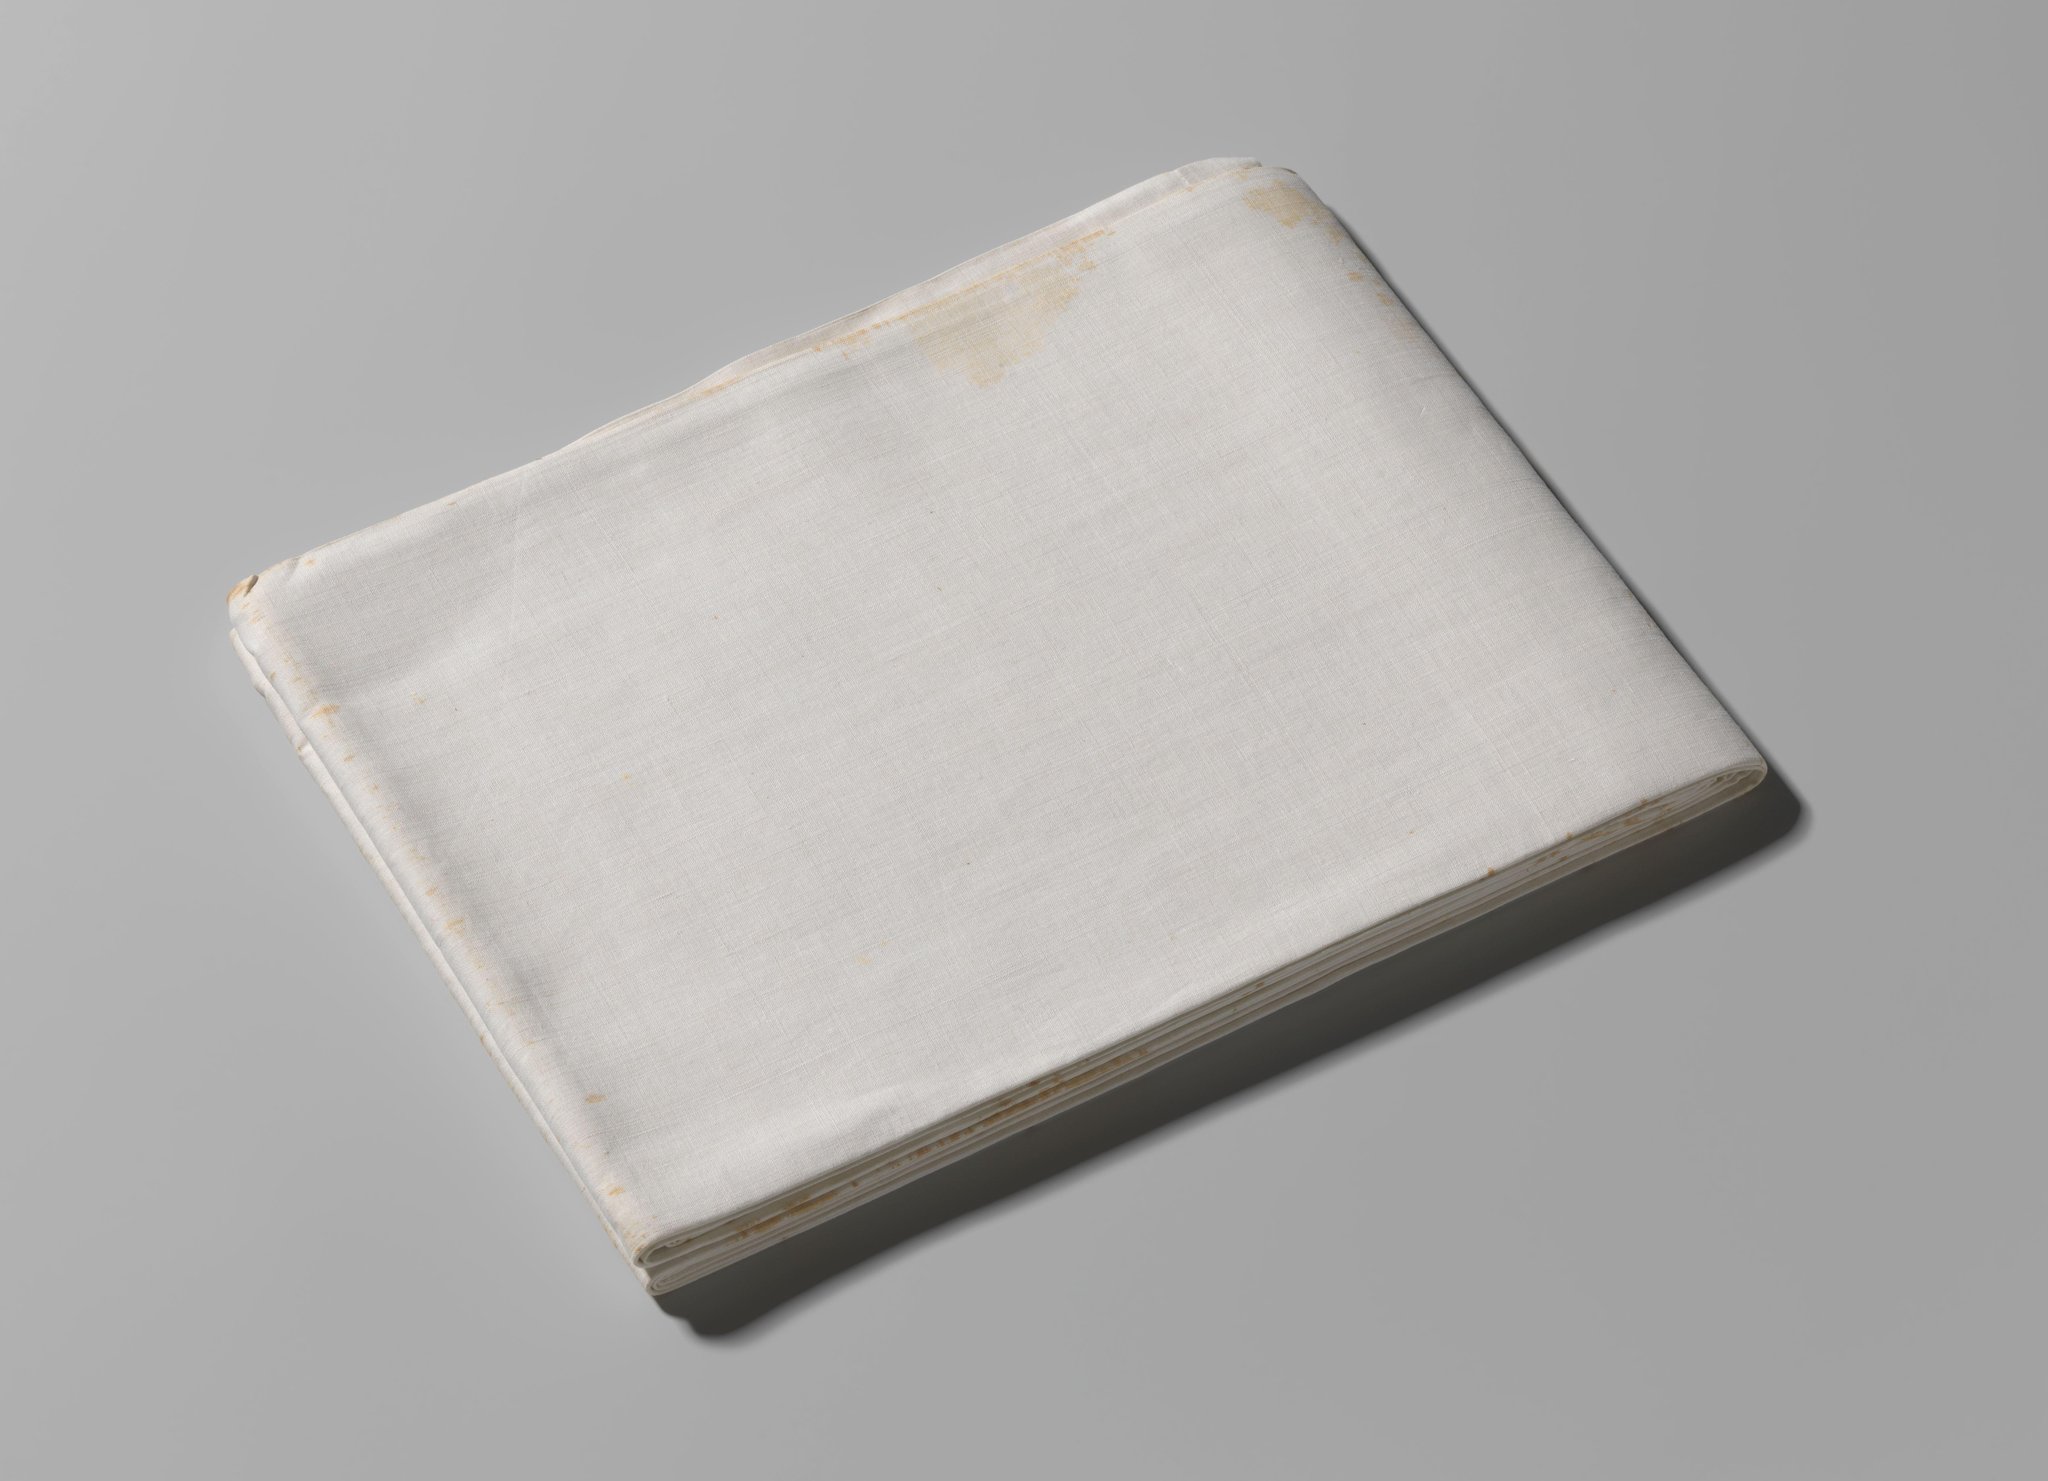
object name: beddenlaken, laken object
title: Laken. Merk: HW14 en jaartal 1847 en WH 2oonl.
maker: Anonymous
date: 1847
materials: linen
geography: netherlands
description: Laken, merk HW 14 en jaartal 1847 en WH 2oonl